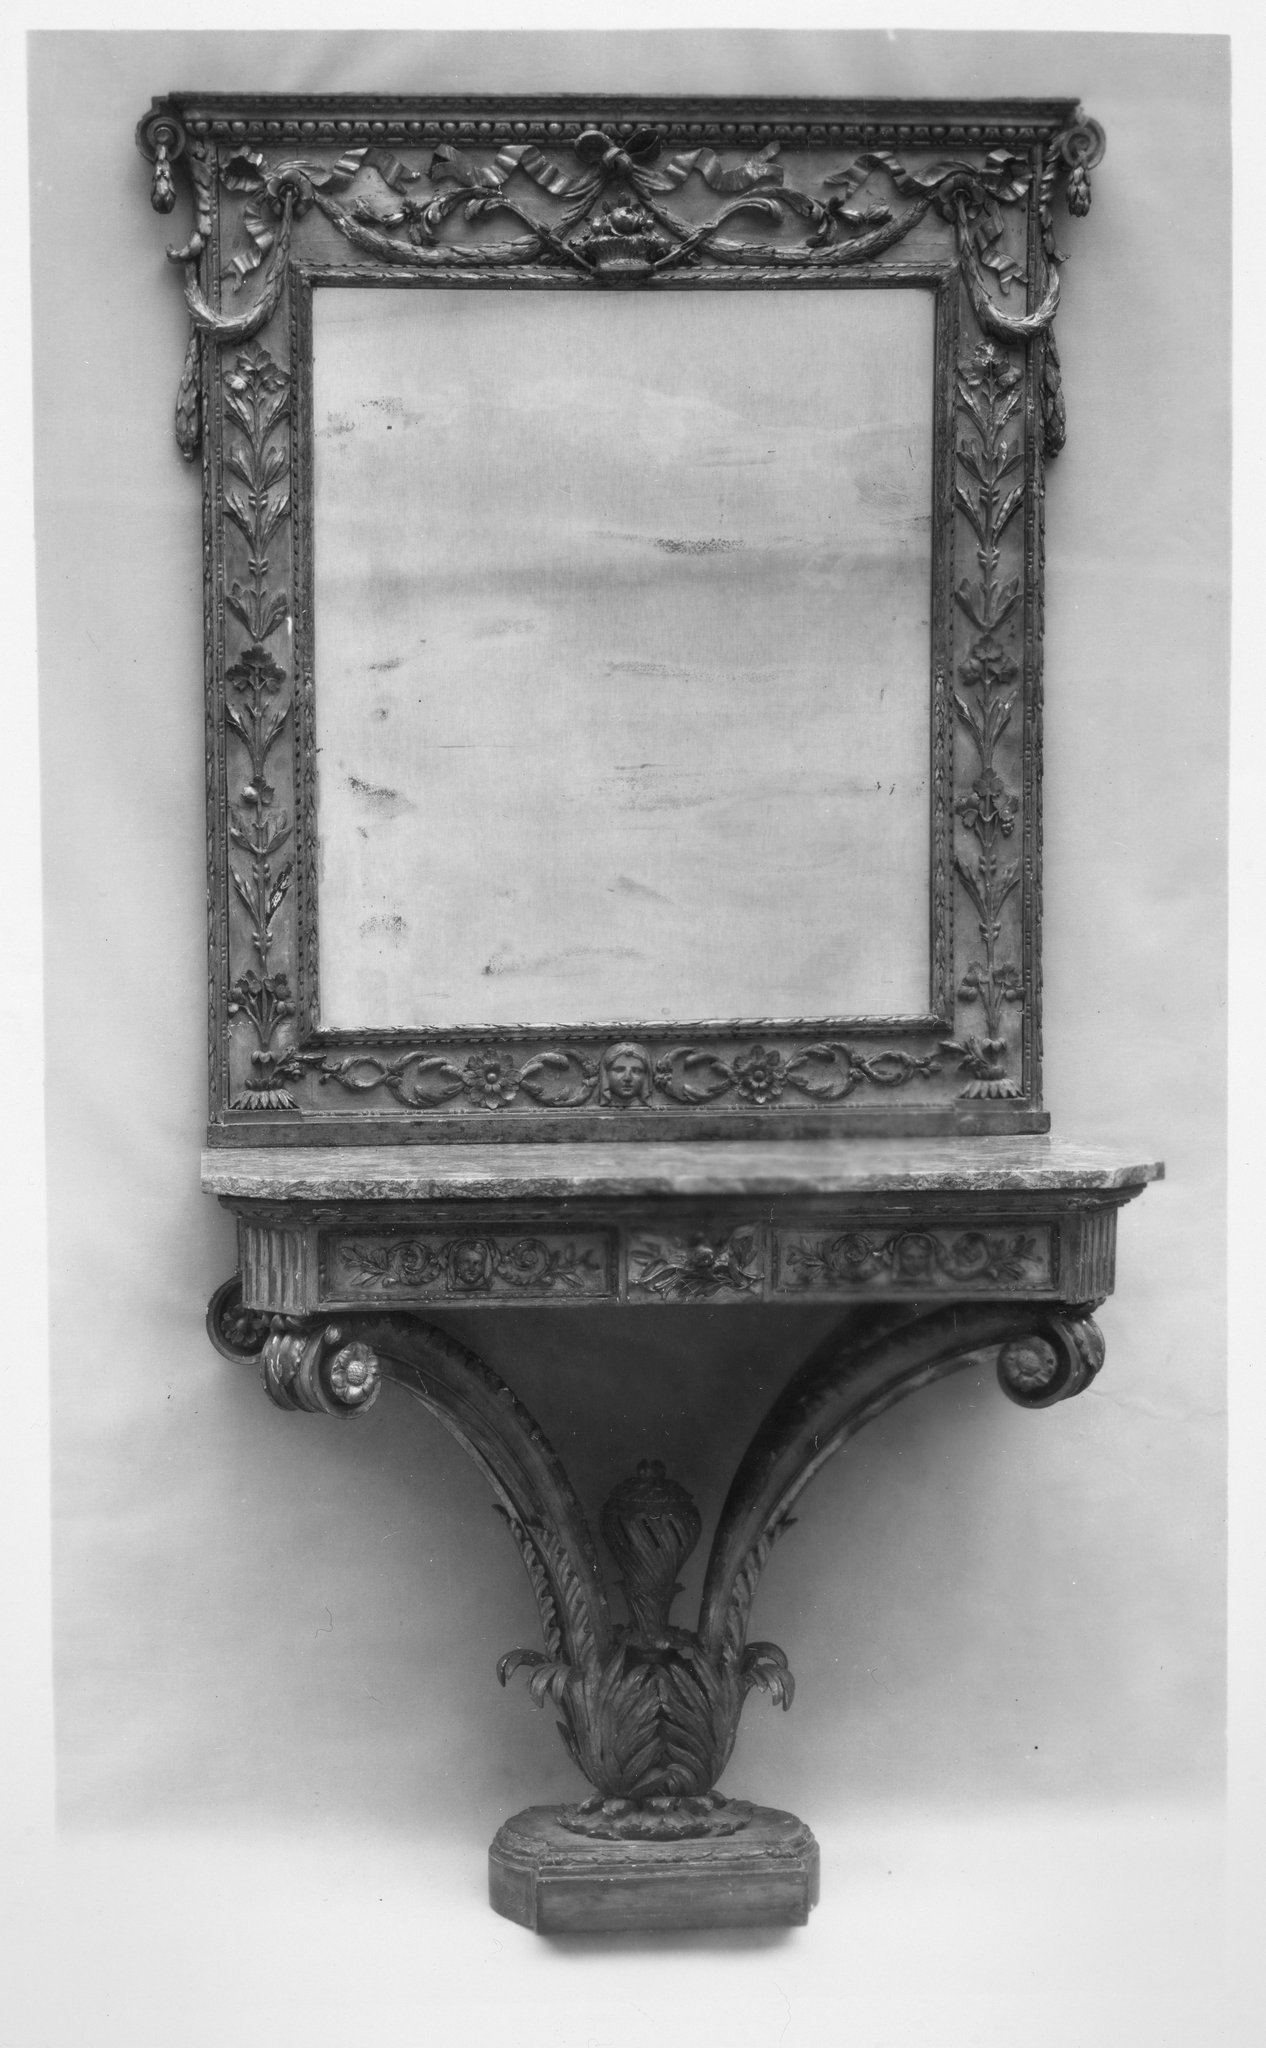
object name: mirror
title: Mirror (part of a set)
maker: giocondo (giuseppe) albertolli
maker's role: maker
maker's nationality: italian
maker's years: 1742-1839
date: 1770-1780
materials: wood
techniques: gilding, painting